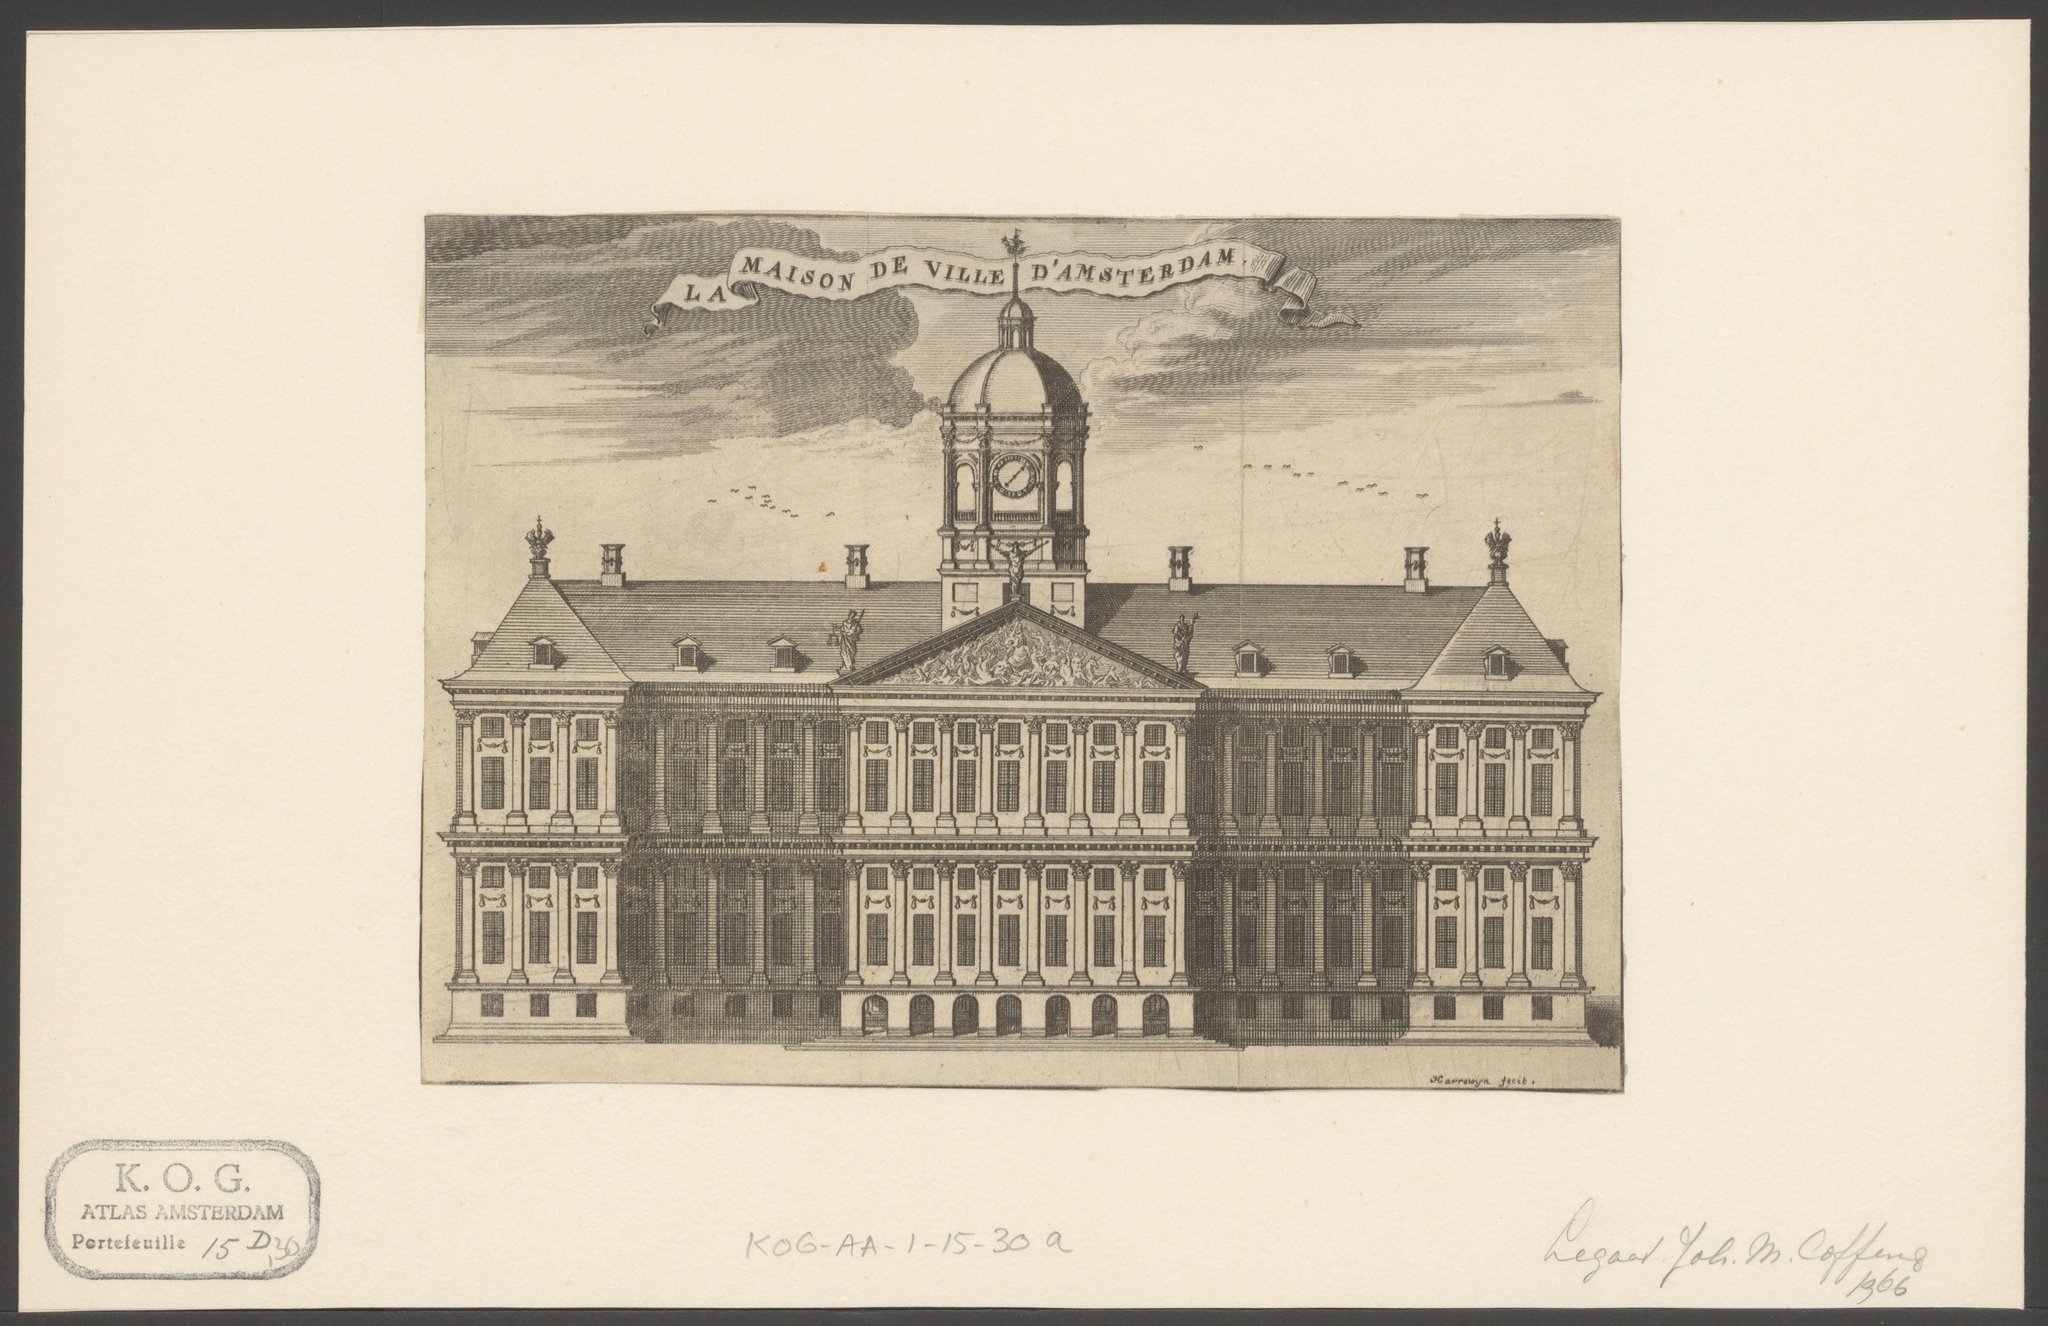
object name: print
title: Gezicht op het Stadhuis op de Dam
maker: jacobus harrewijn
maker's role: print maker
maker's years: 1660-1740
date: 1743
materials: paper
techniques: etching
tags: city-view in general; 'veduta', townhall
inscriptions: collector's mark: ‘15D,30’ Lugt 1641b, inscription: ‘Legaat Joh. M. Coffeng / 1966’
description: Prent waarschijnlijk uit: Christyn, Jean Baptiste. Histoire Generale Des Pais-Bas. Contenant la Description Des XVII Province (...). Brussel: weduwe François Foppens, 1743.